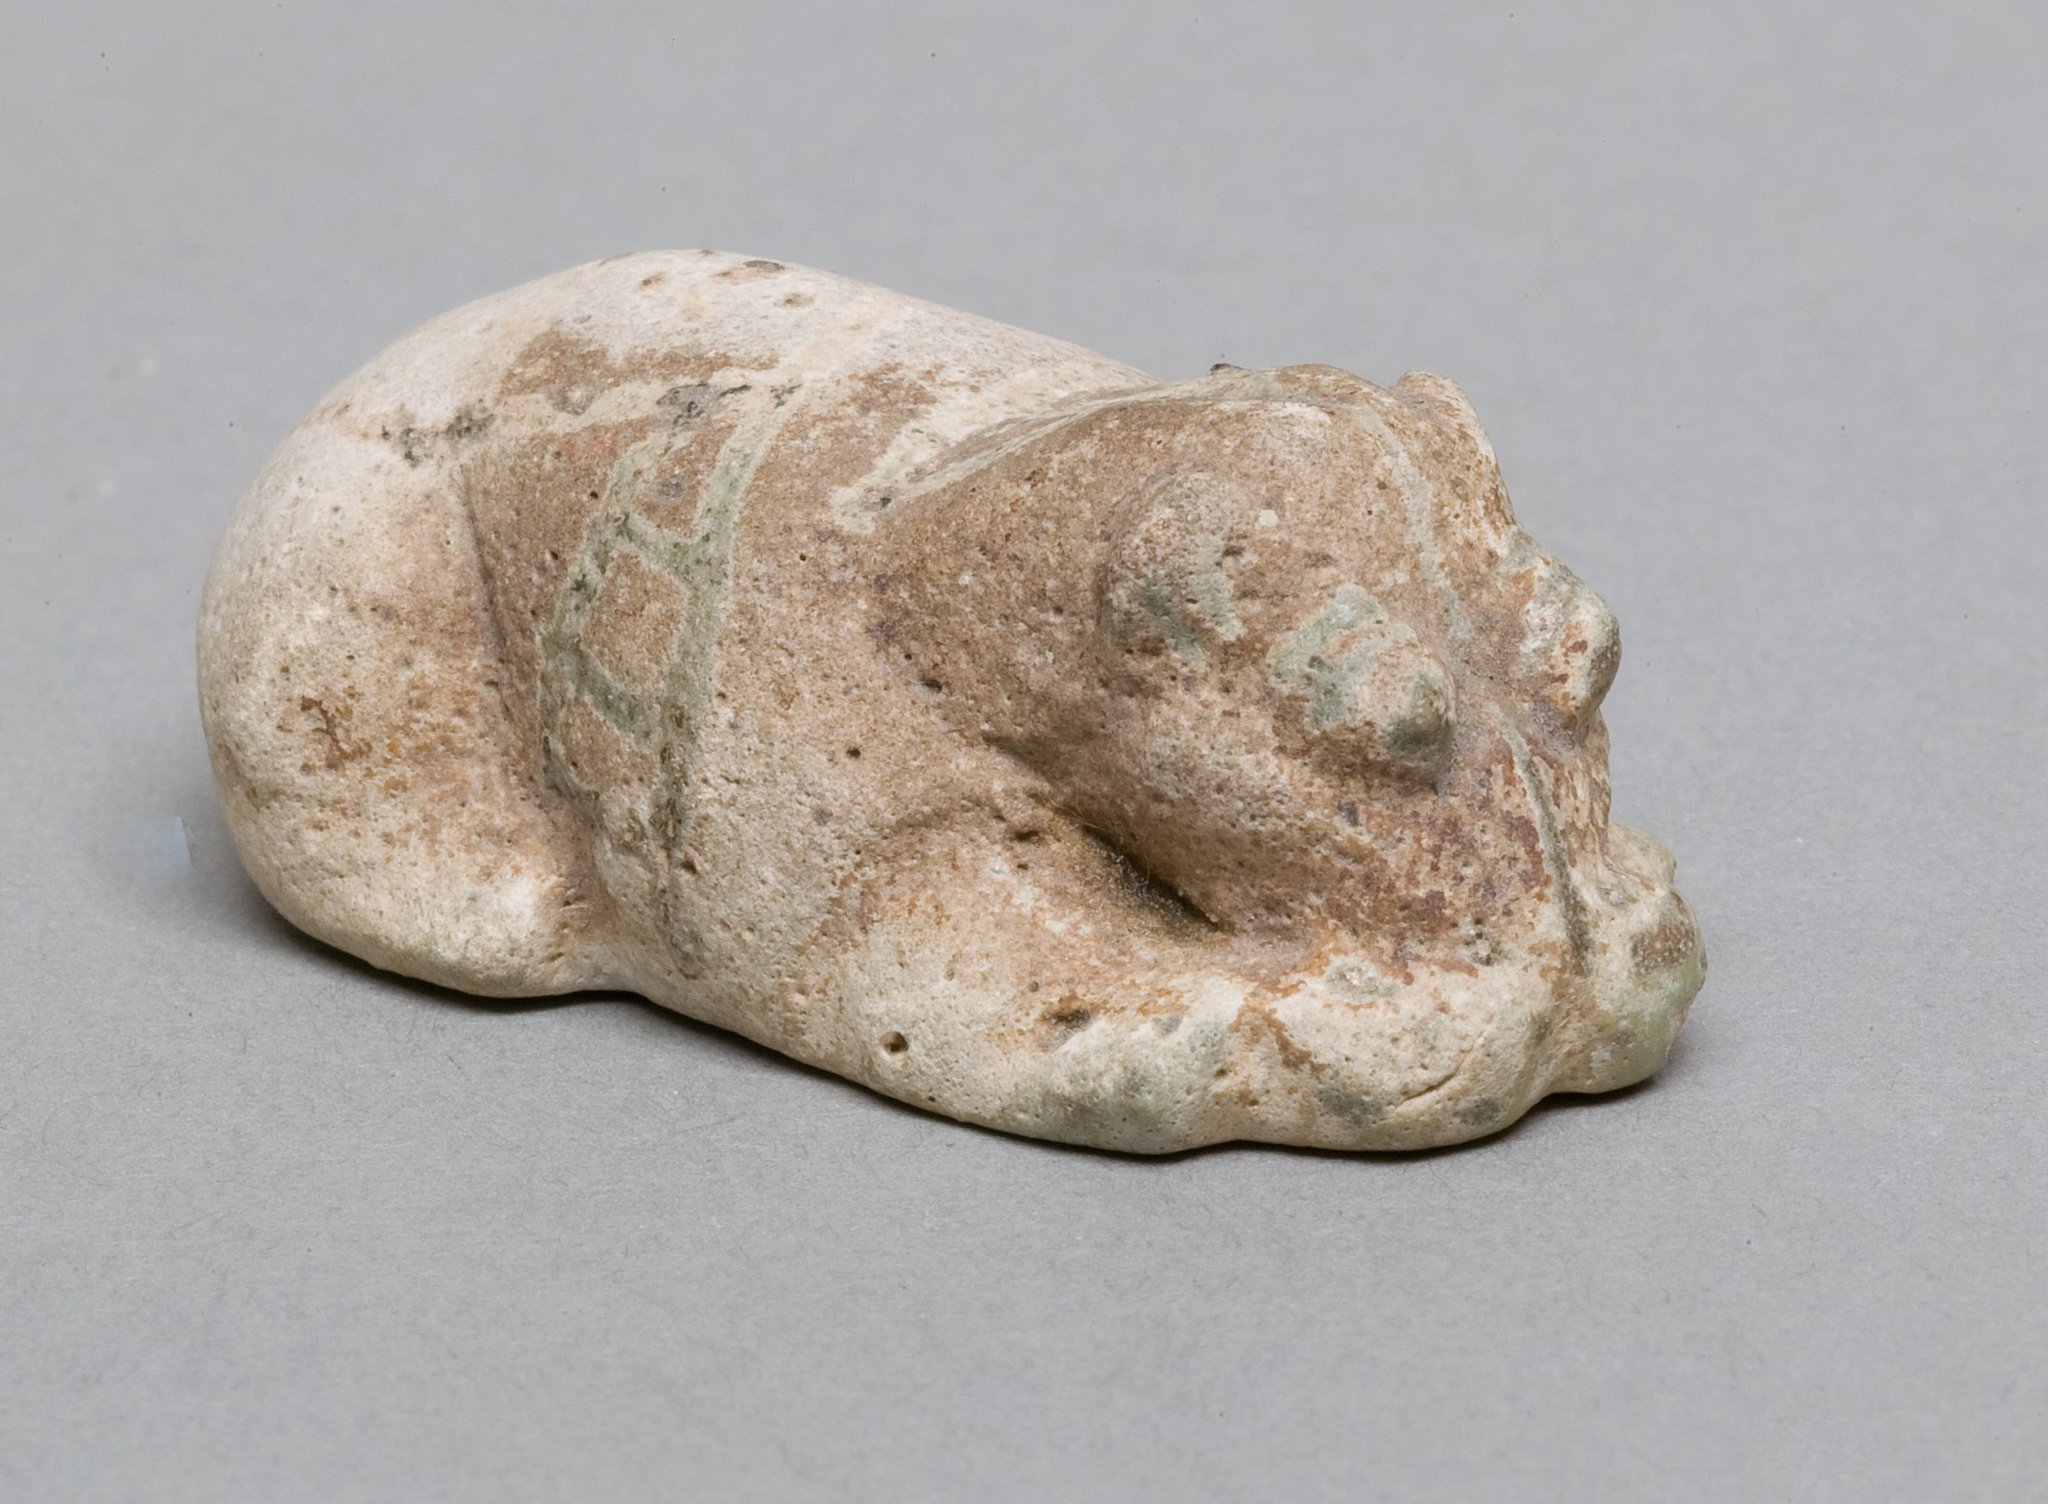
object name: figurine, hippopotamus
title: Hippopotamus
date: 1850-1640 BCE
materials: faience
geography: egypt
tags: hippos